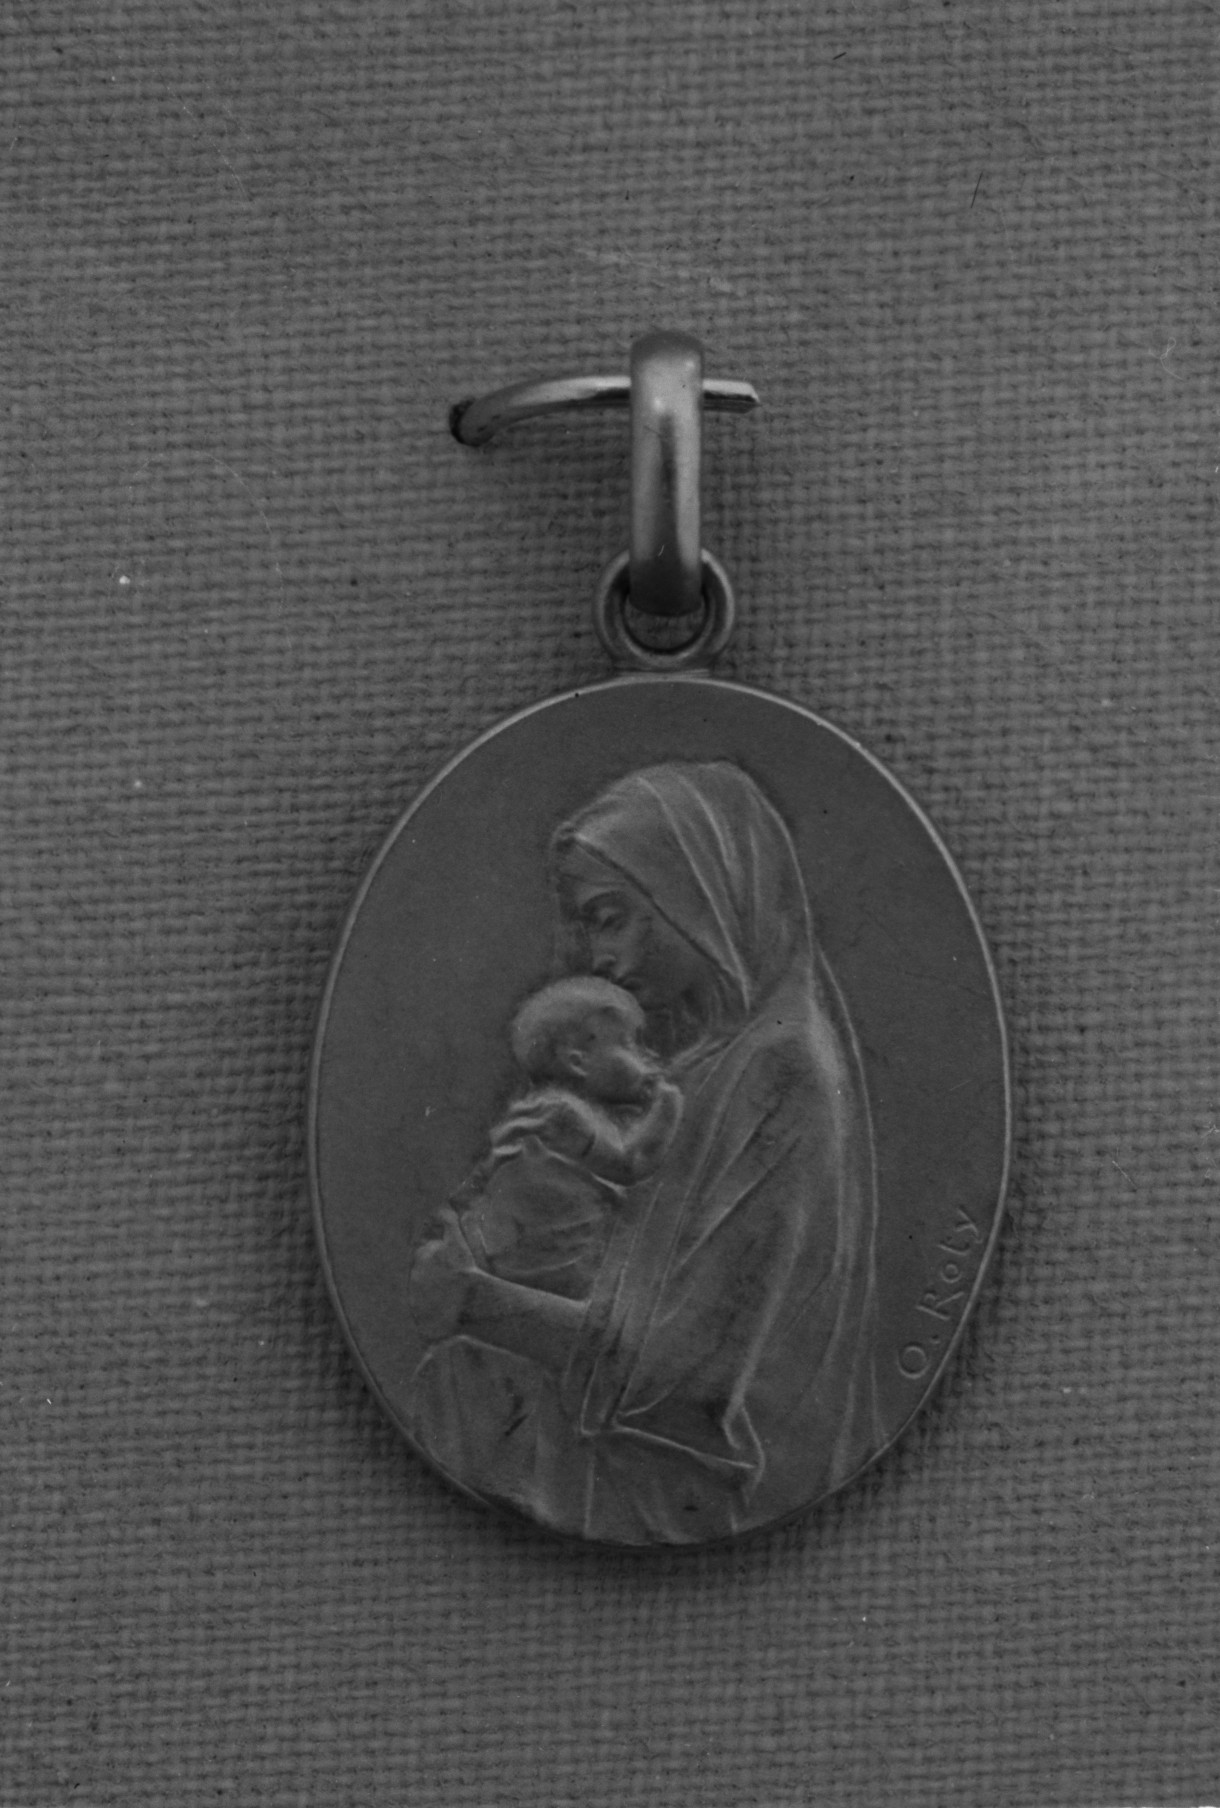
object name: medal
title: Virgin and Child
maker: louis-oscar roty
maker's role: artist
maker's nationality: french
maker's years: 1846-1911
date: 1801-1900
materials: gold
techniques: struck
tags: christ,madonna and child,virgin mary